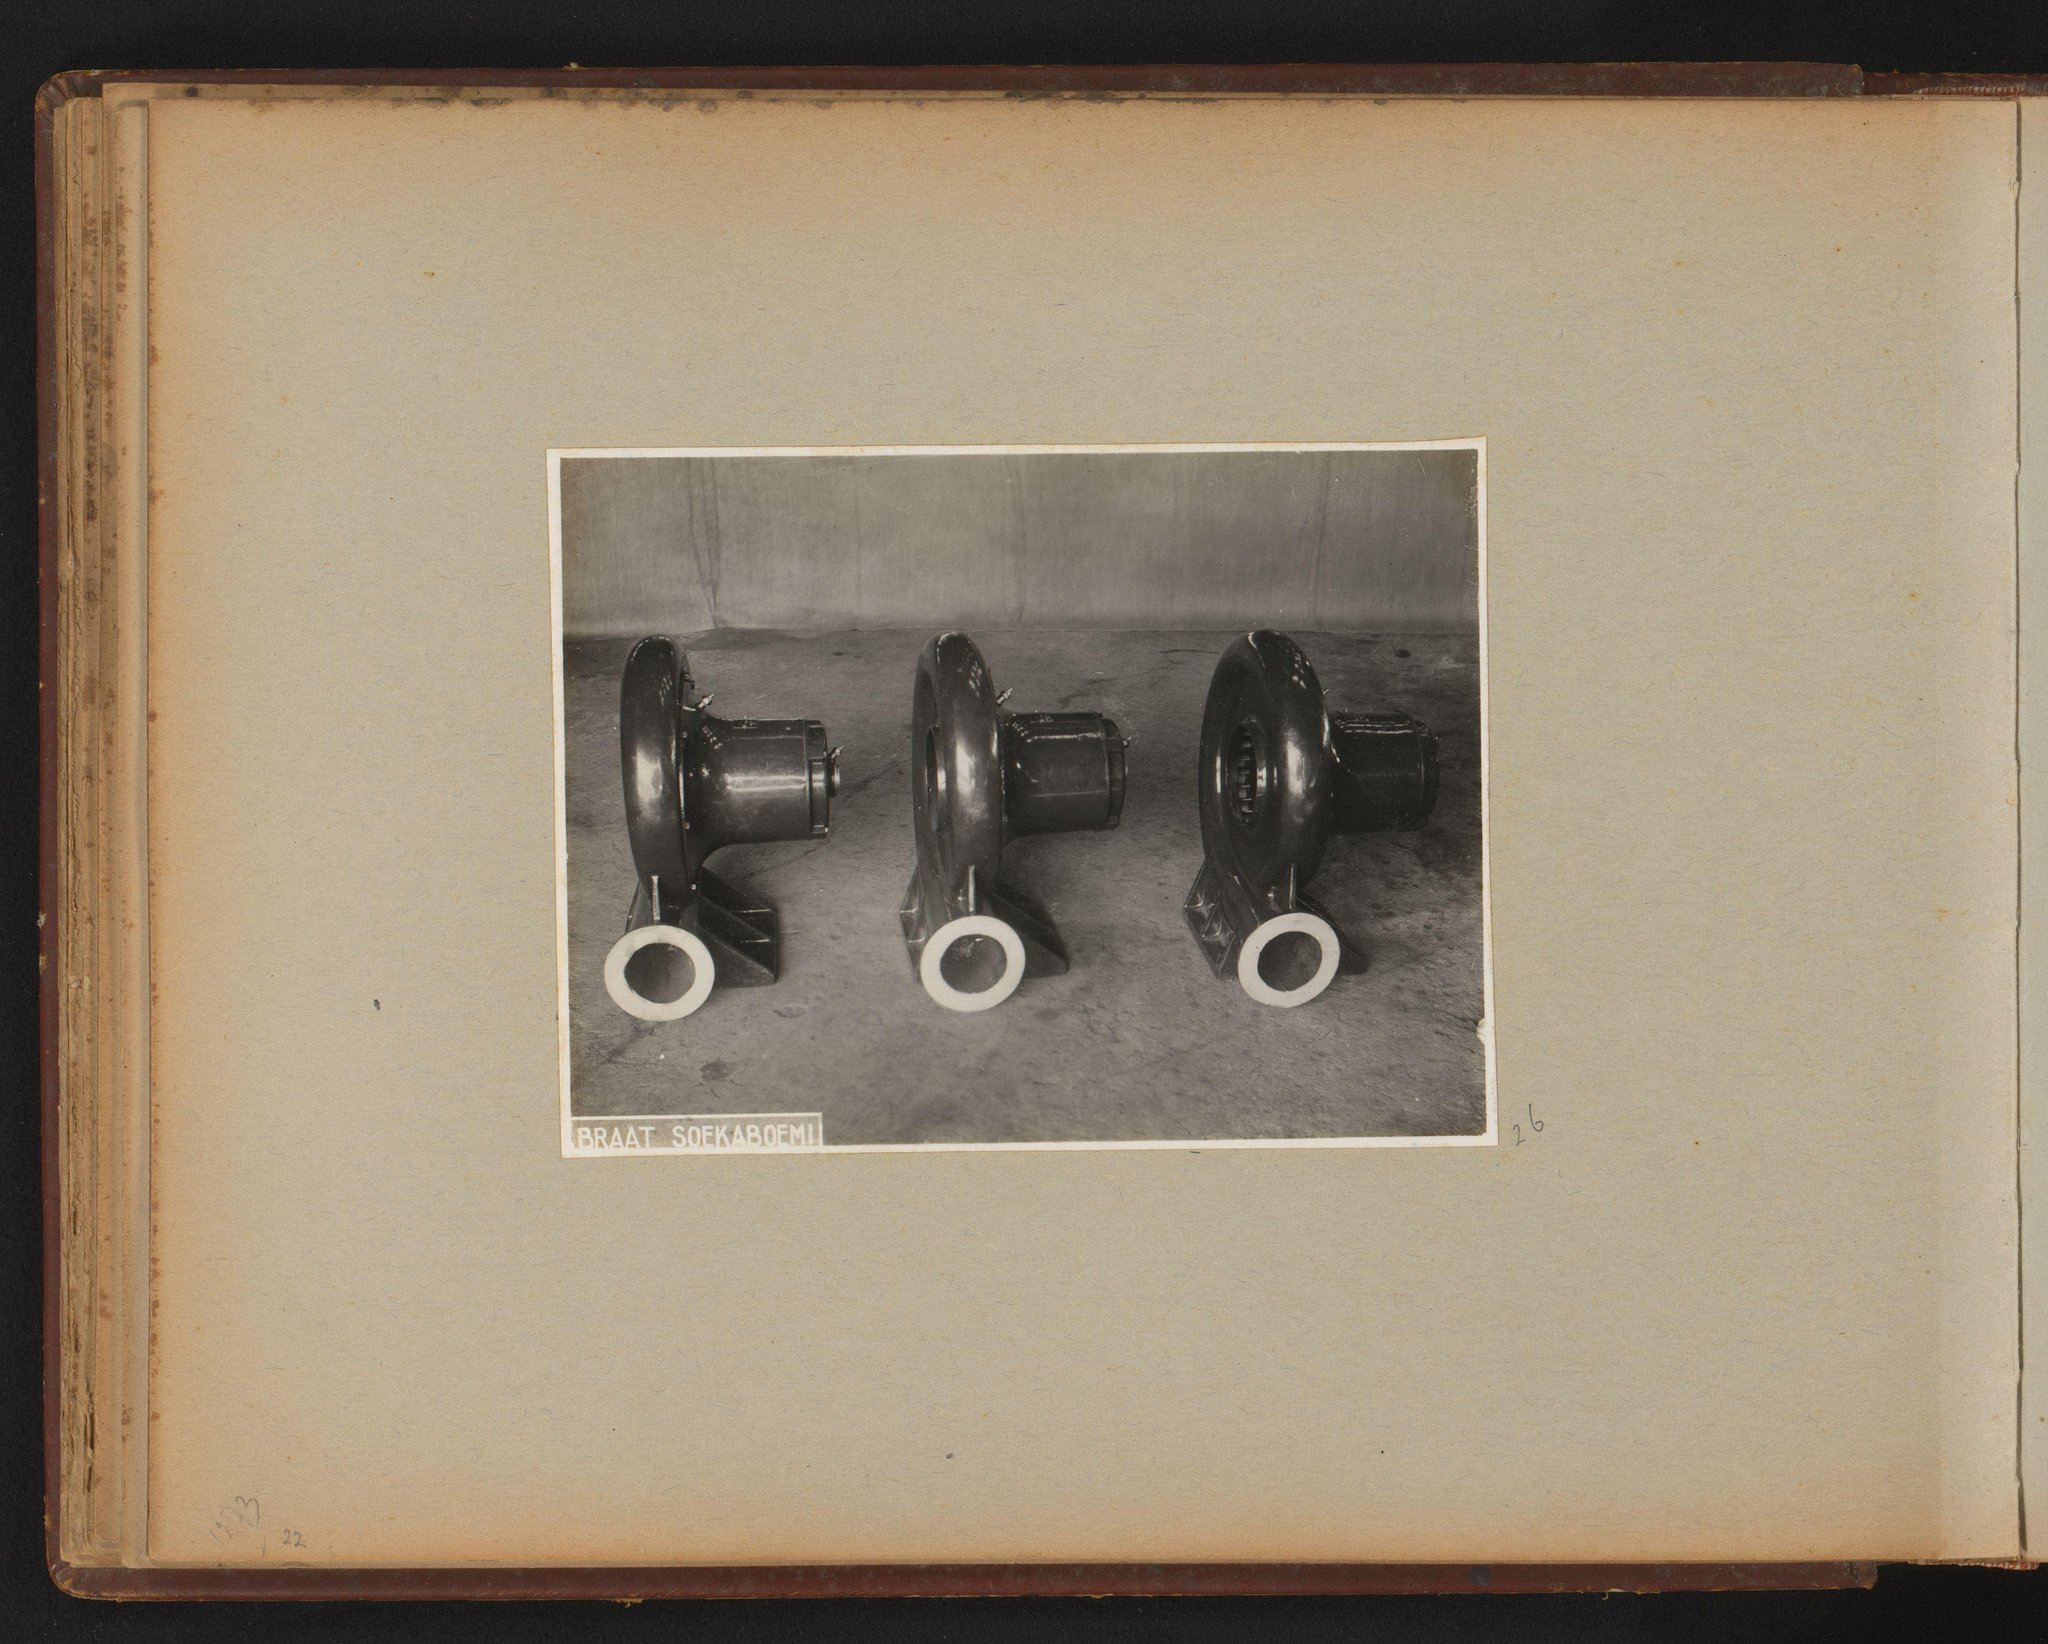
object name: album leaf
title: Machineonderdelen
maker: Anonymous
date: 1931-1937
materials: cardboard, photographic support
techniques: gelatin silver print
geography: soekaboemi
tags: parts of machines, java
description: Albumblad met een foto van drie onderdelen voor een machine. Onderdeel van een fotoalbum met foto's van machines en constructies van de N.V. Machinefabriek Braat te Soerabaja, Soekaboemi en Tegal uit de periode 1931-1937.